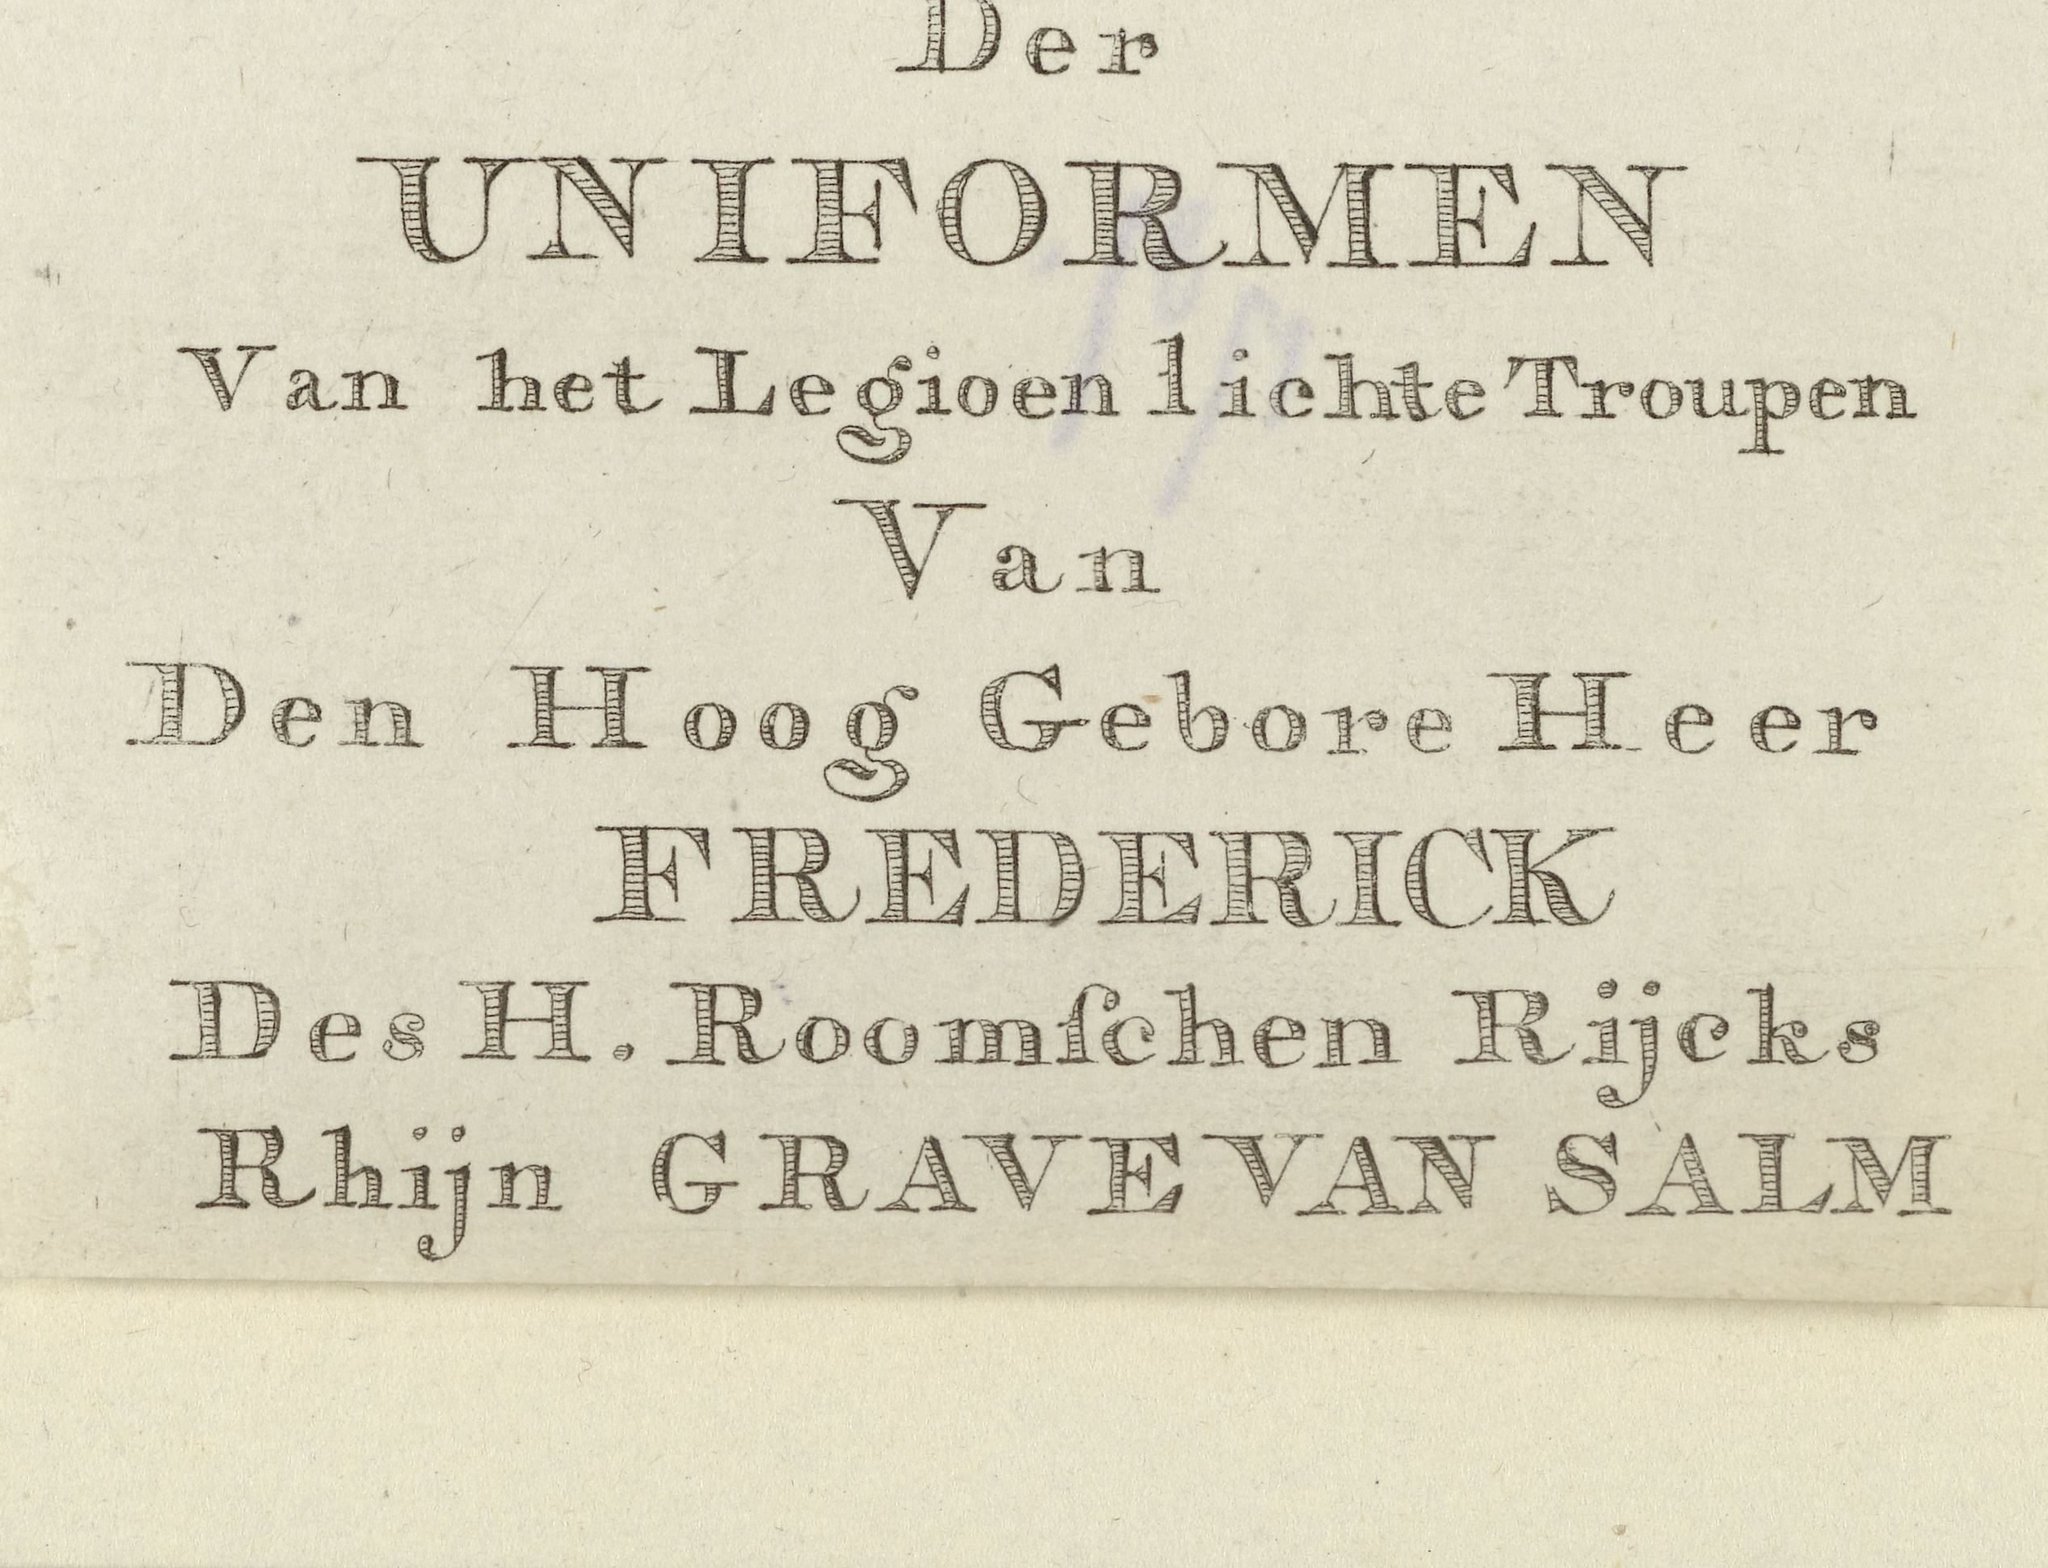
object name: print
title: Uniformen van het legioen van de Rijngraaf van Salm, 1785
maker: Anonymous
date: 1785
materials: paper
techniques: etching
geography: northern netherlands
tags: rijngraaf van salm frederik iii, patriots (1780-1795)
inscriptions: collector's mark: Lugt 2228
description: Serietitel. Onderdeel van de prentserie van uniformen van het legioen van Frederik III Rijngraaf van Salm, in dienst van Republiek in 1785.